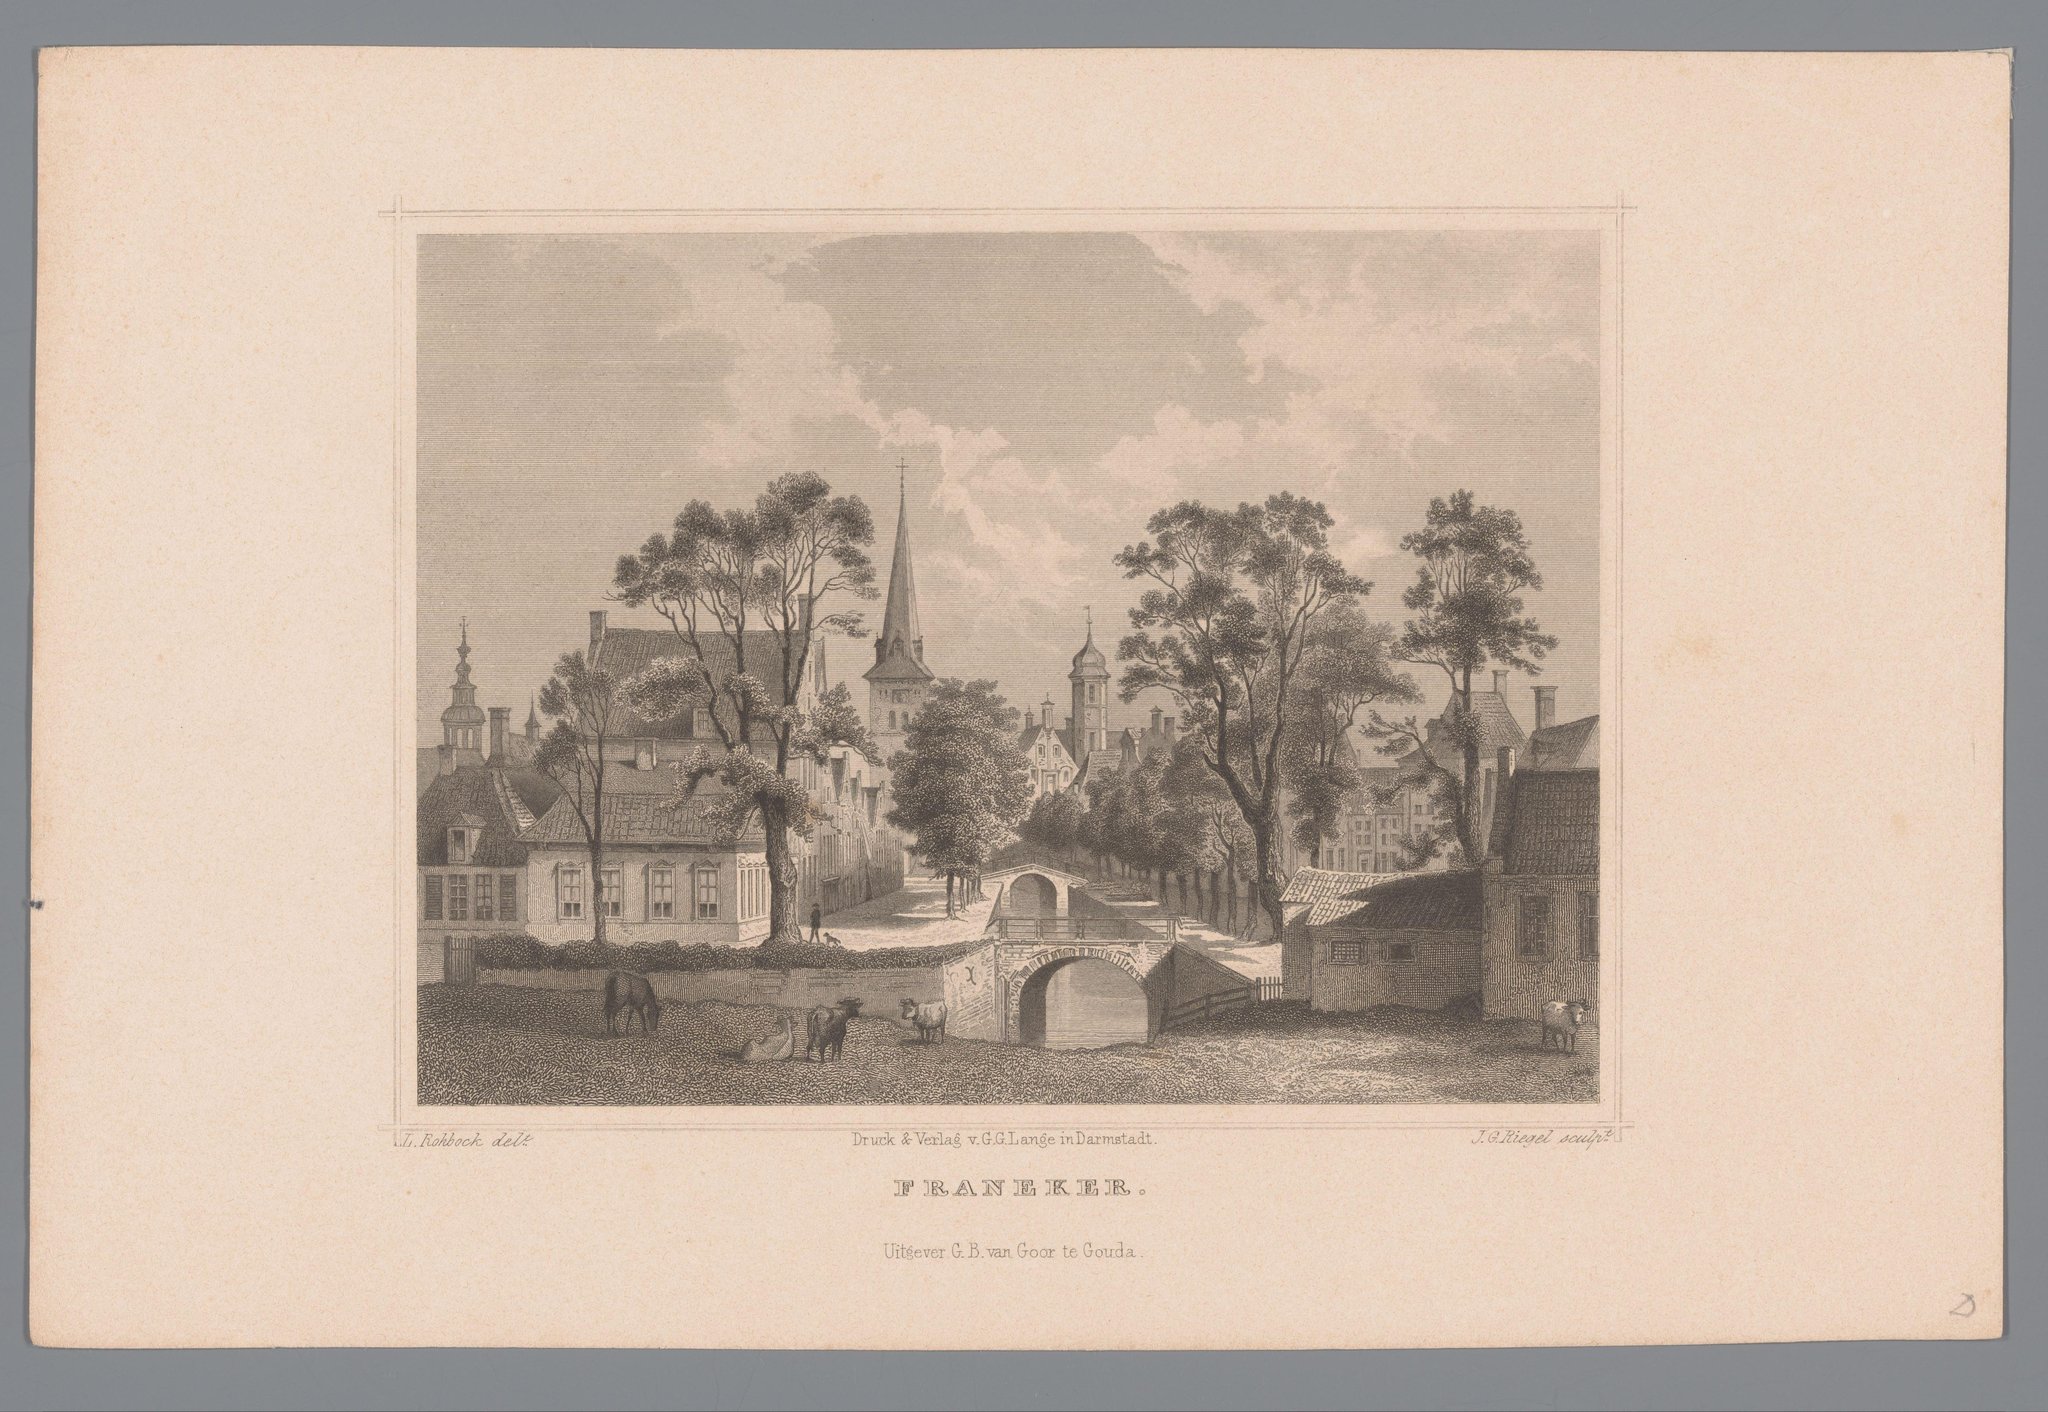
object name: print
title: Gezicht op Franeker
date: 1858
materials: paper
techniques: engraving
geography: darmstadt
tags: village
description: Prent verschenen in: Terwen, Johannes Leonardus. Het Koningrijk der Nederlanden: voorgesteld in eene reeks van naar de natuur geteekende schilderachtige gezigten en beschreven. Gouda: G.B. van Goor, 1858, dl. 3.